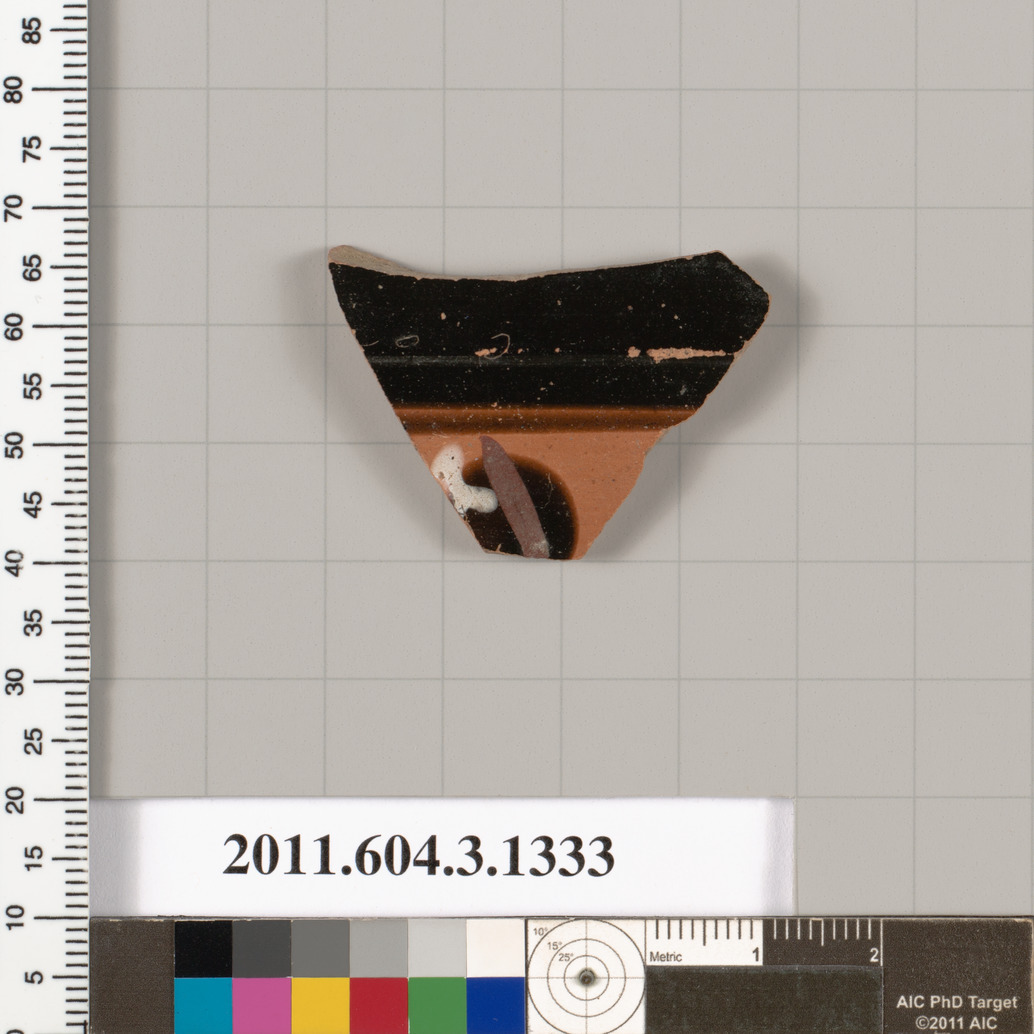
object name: skyphos fragment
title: Terracotta fragment of a skyphos (deep drinking cup)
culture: greek, attic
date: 500-468 BCE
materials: terracotta